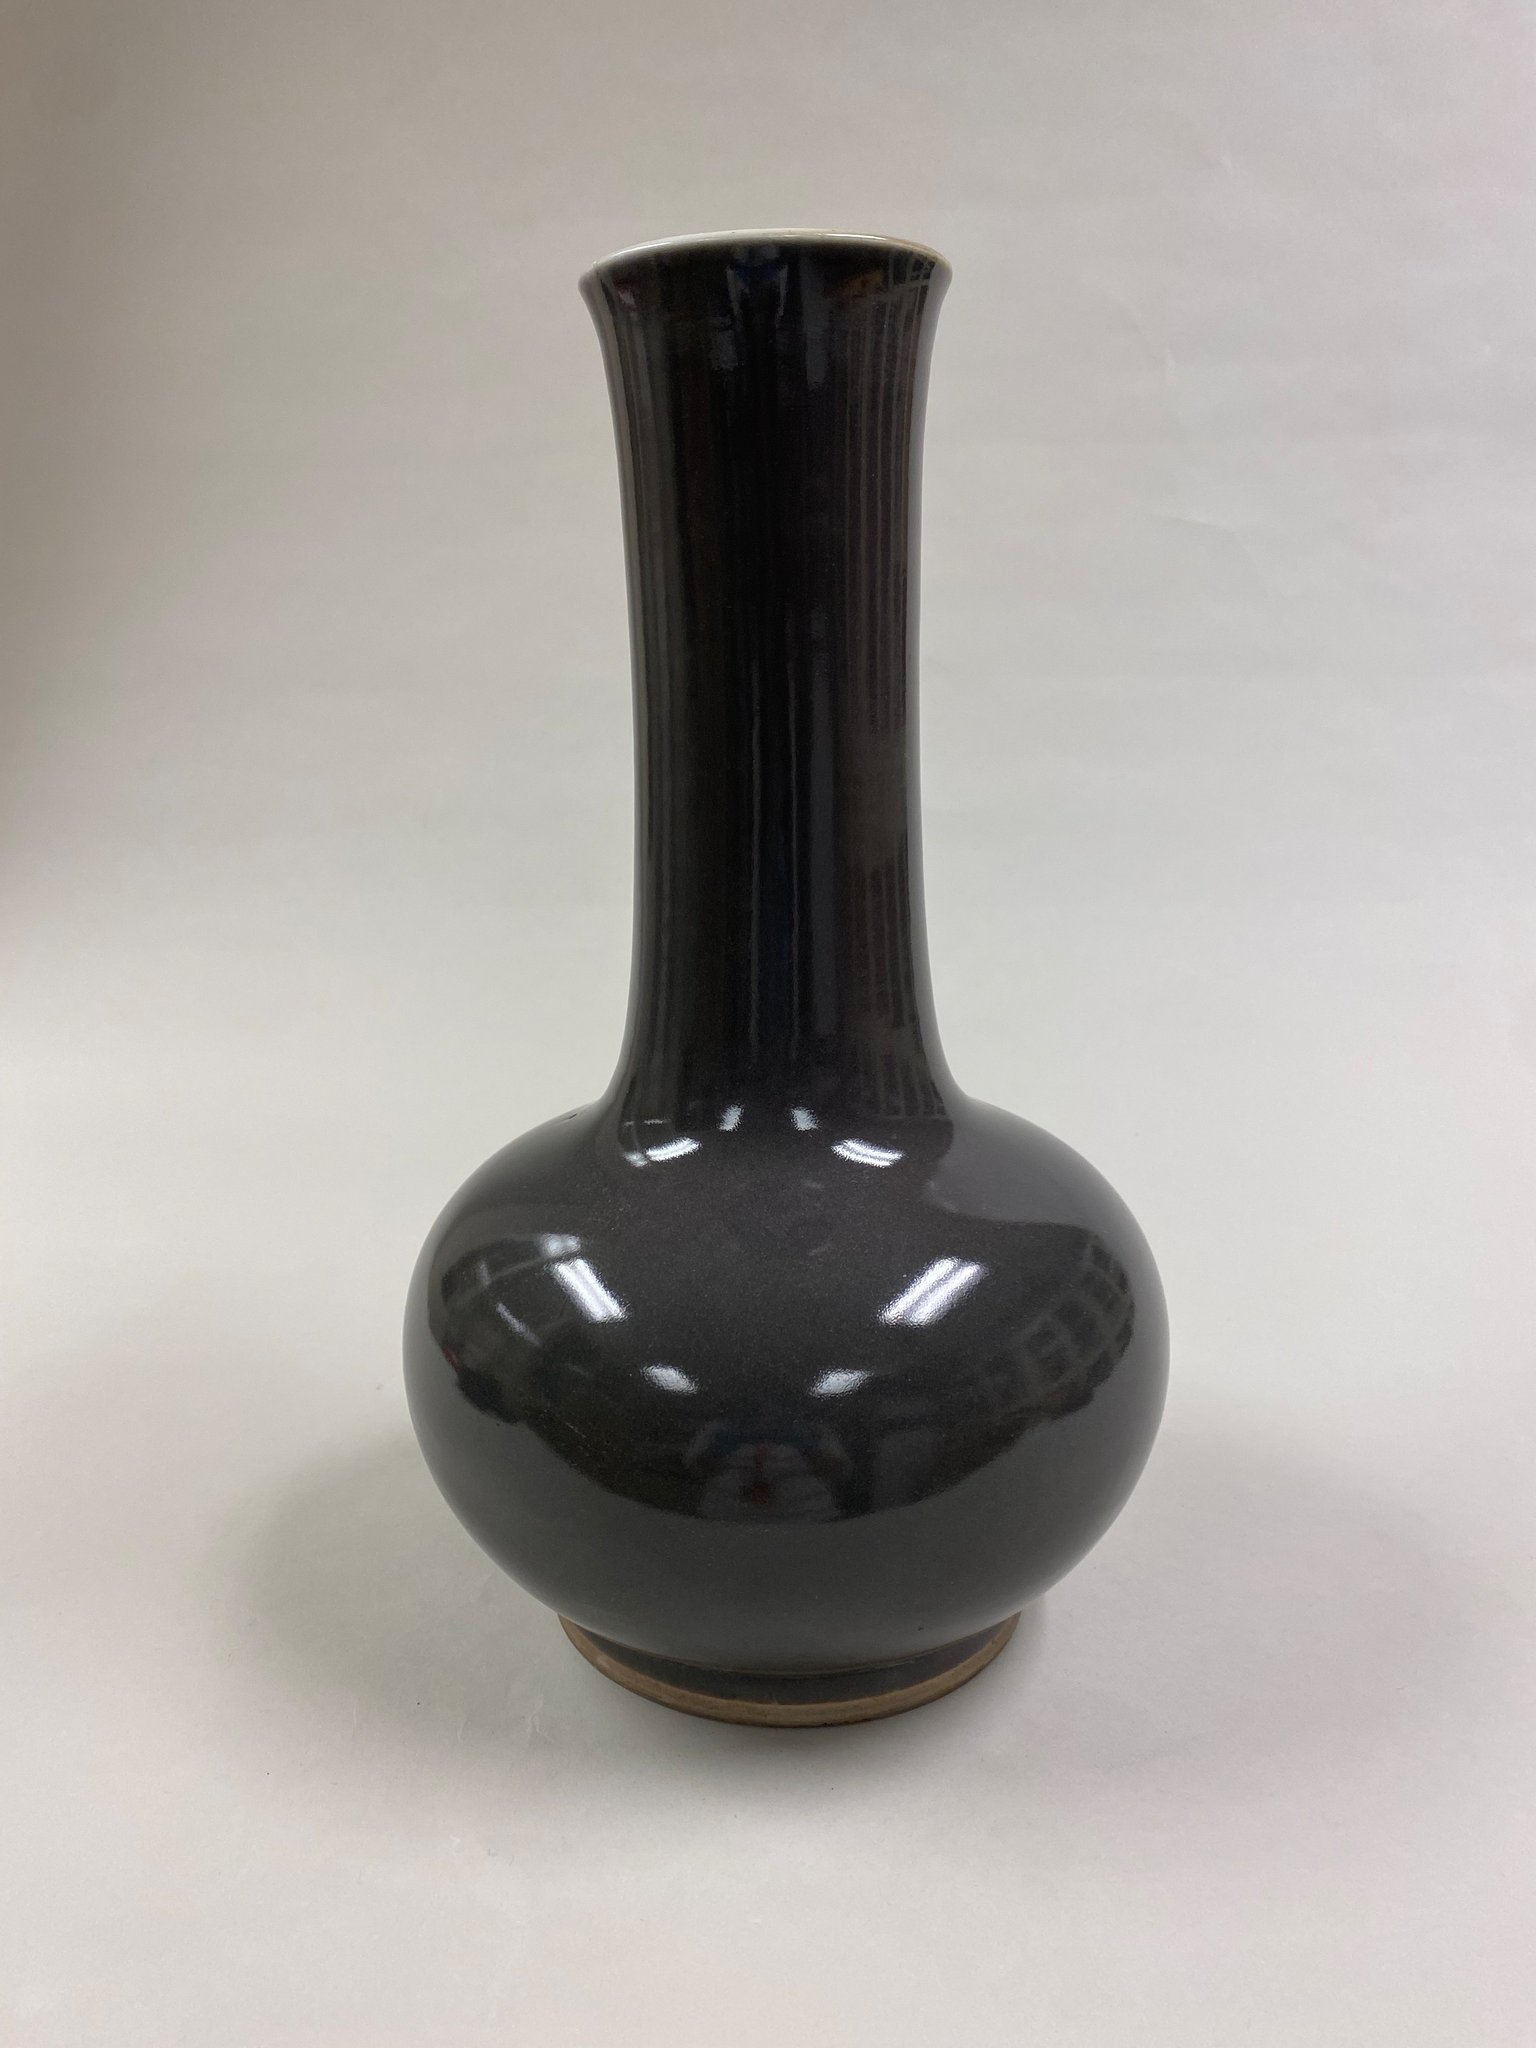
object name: bottle vase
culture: chinese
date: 1701-1800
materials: glaze, porcelain